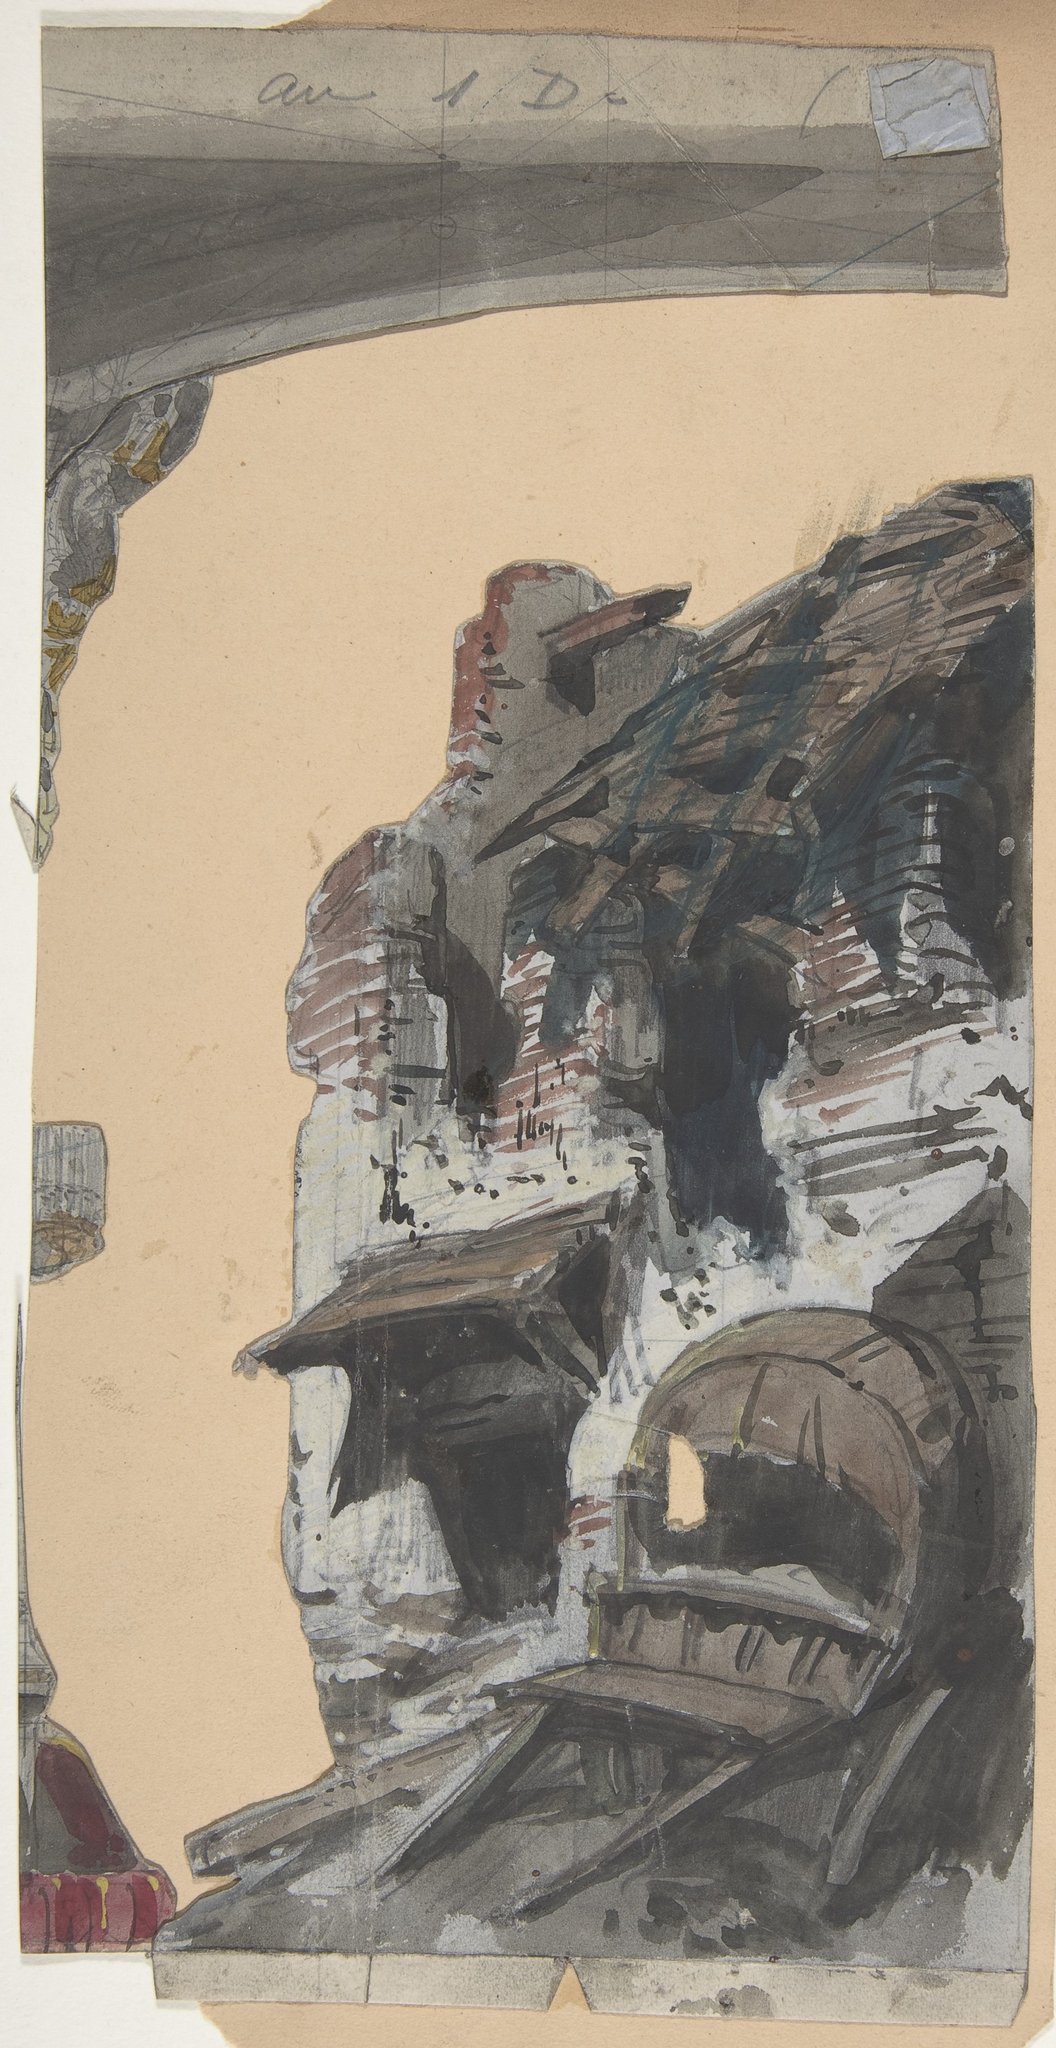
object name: drawing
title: Design for a Stage Set at the Opéra, Paris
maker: eugène cicéri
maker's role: artist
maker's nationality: french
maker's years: 1813-1890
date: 1830-1890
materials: gouache, graphite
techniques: brush, wash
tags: stage design